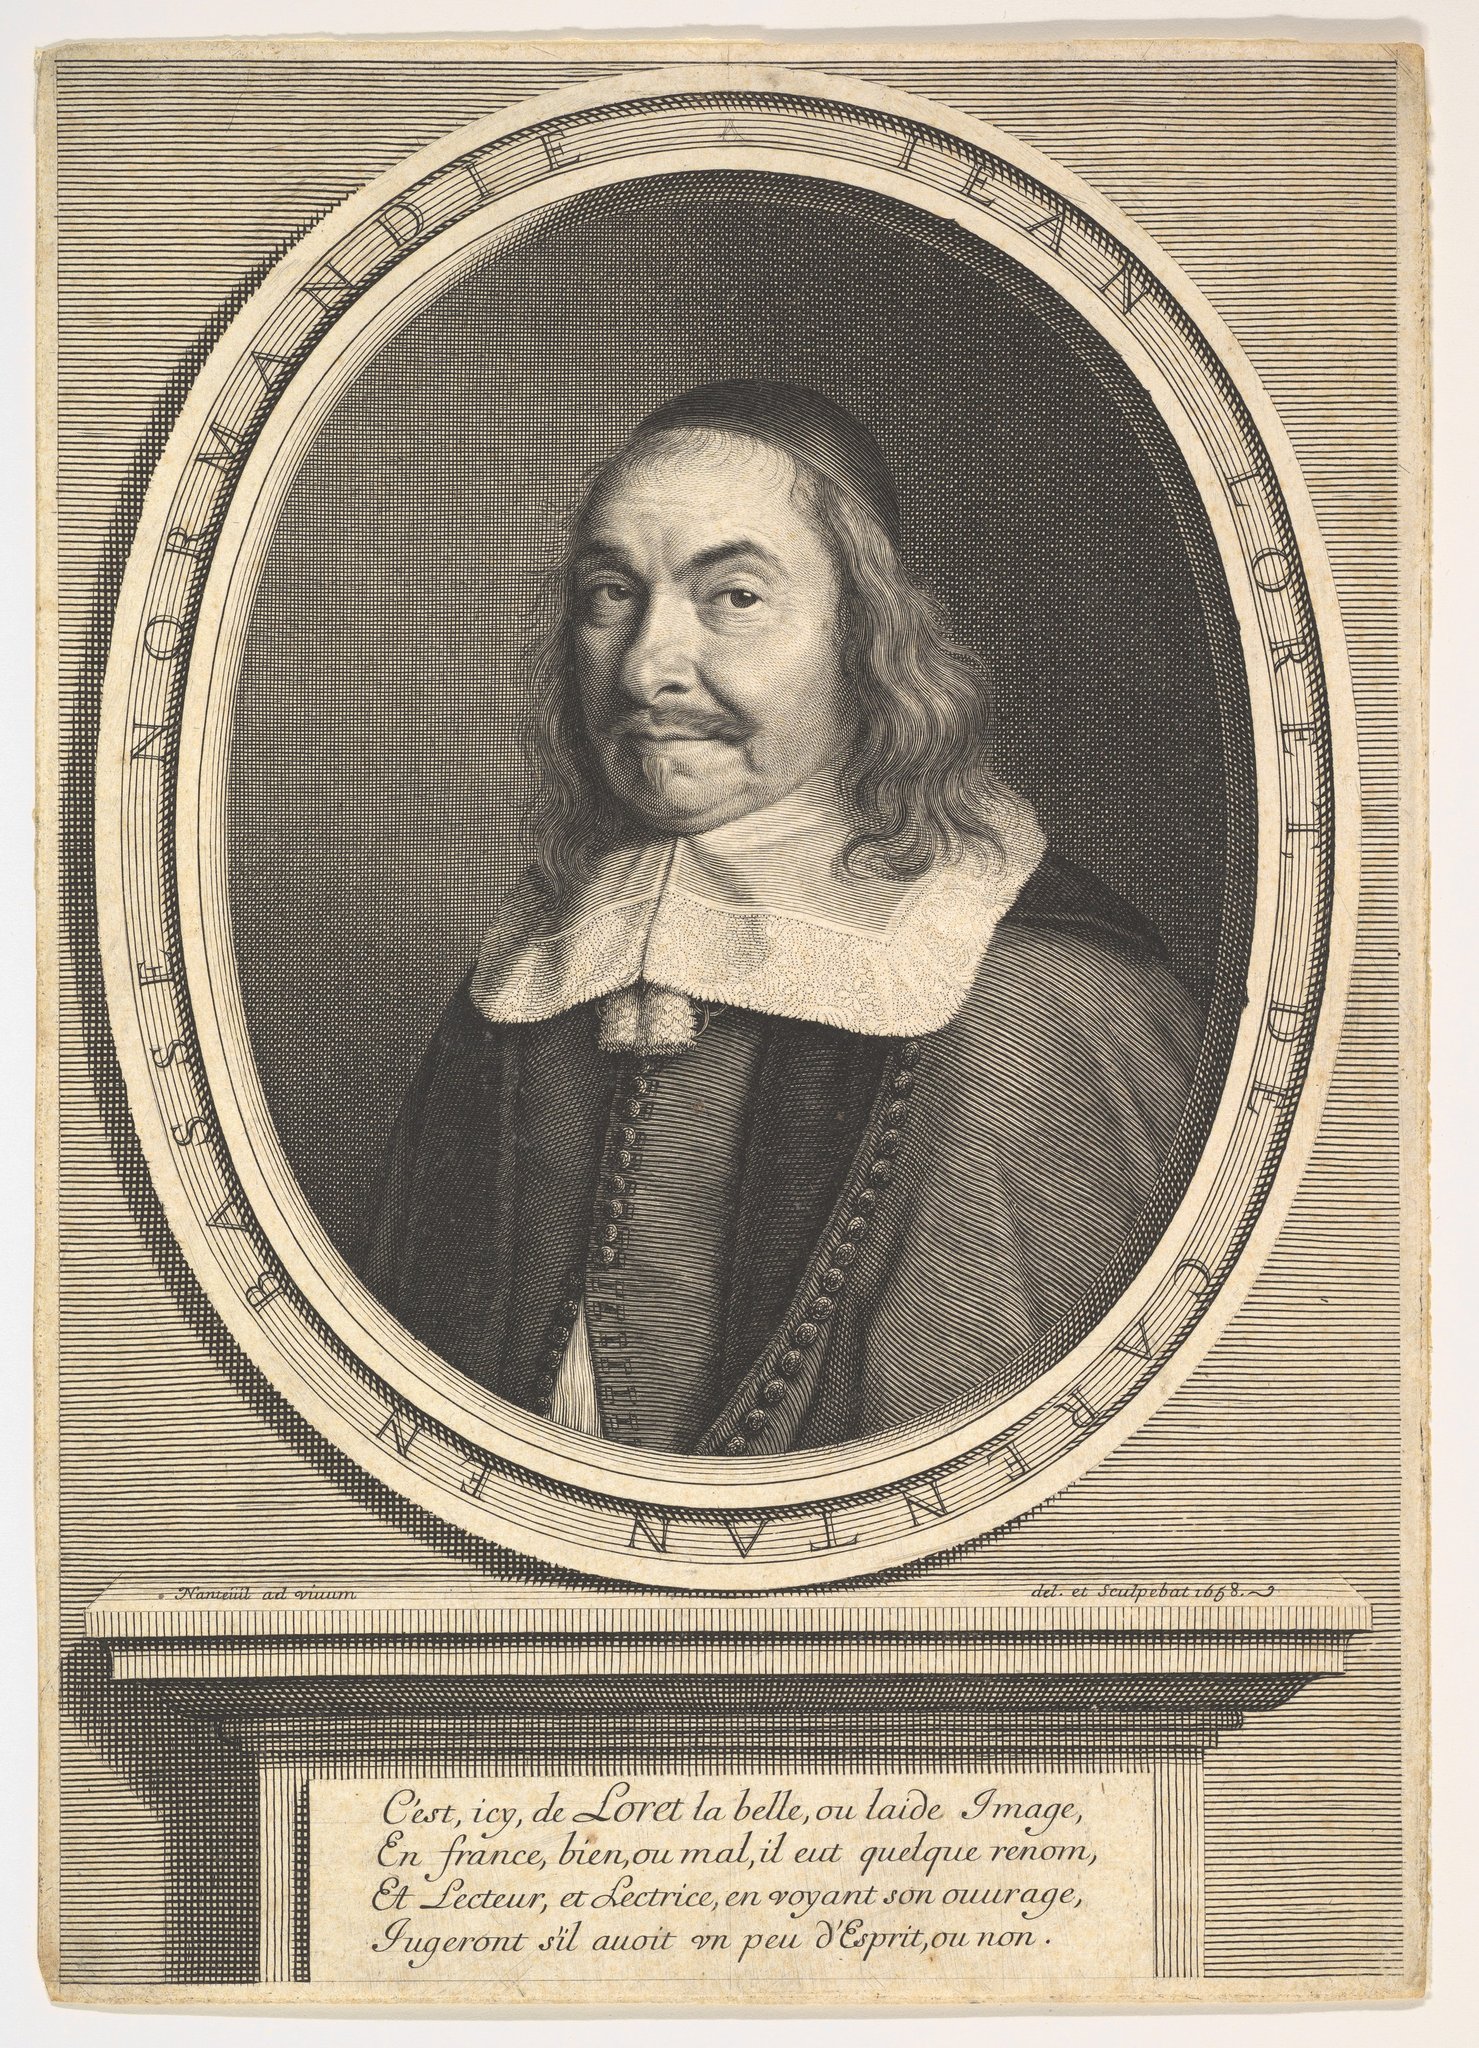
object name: print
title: Portrait of Jean Loret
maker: robert nanteuil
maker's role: artist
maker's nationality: french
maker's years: 1623-1678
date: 1601-1700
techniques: engraving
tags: men,portraits